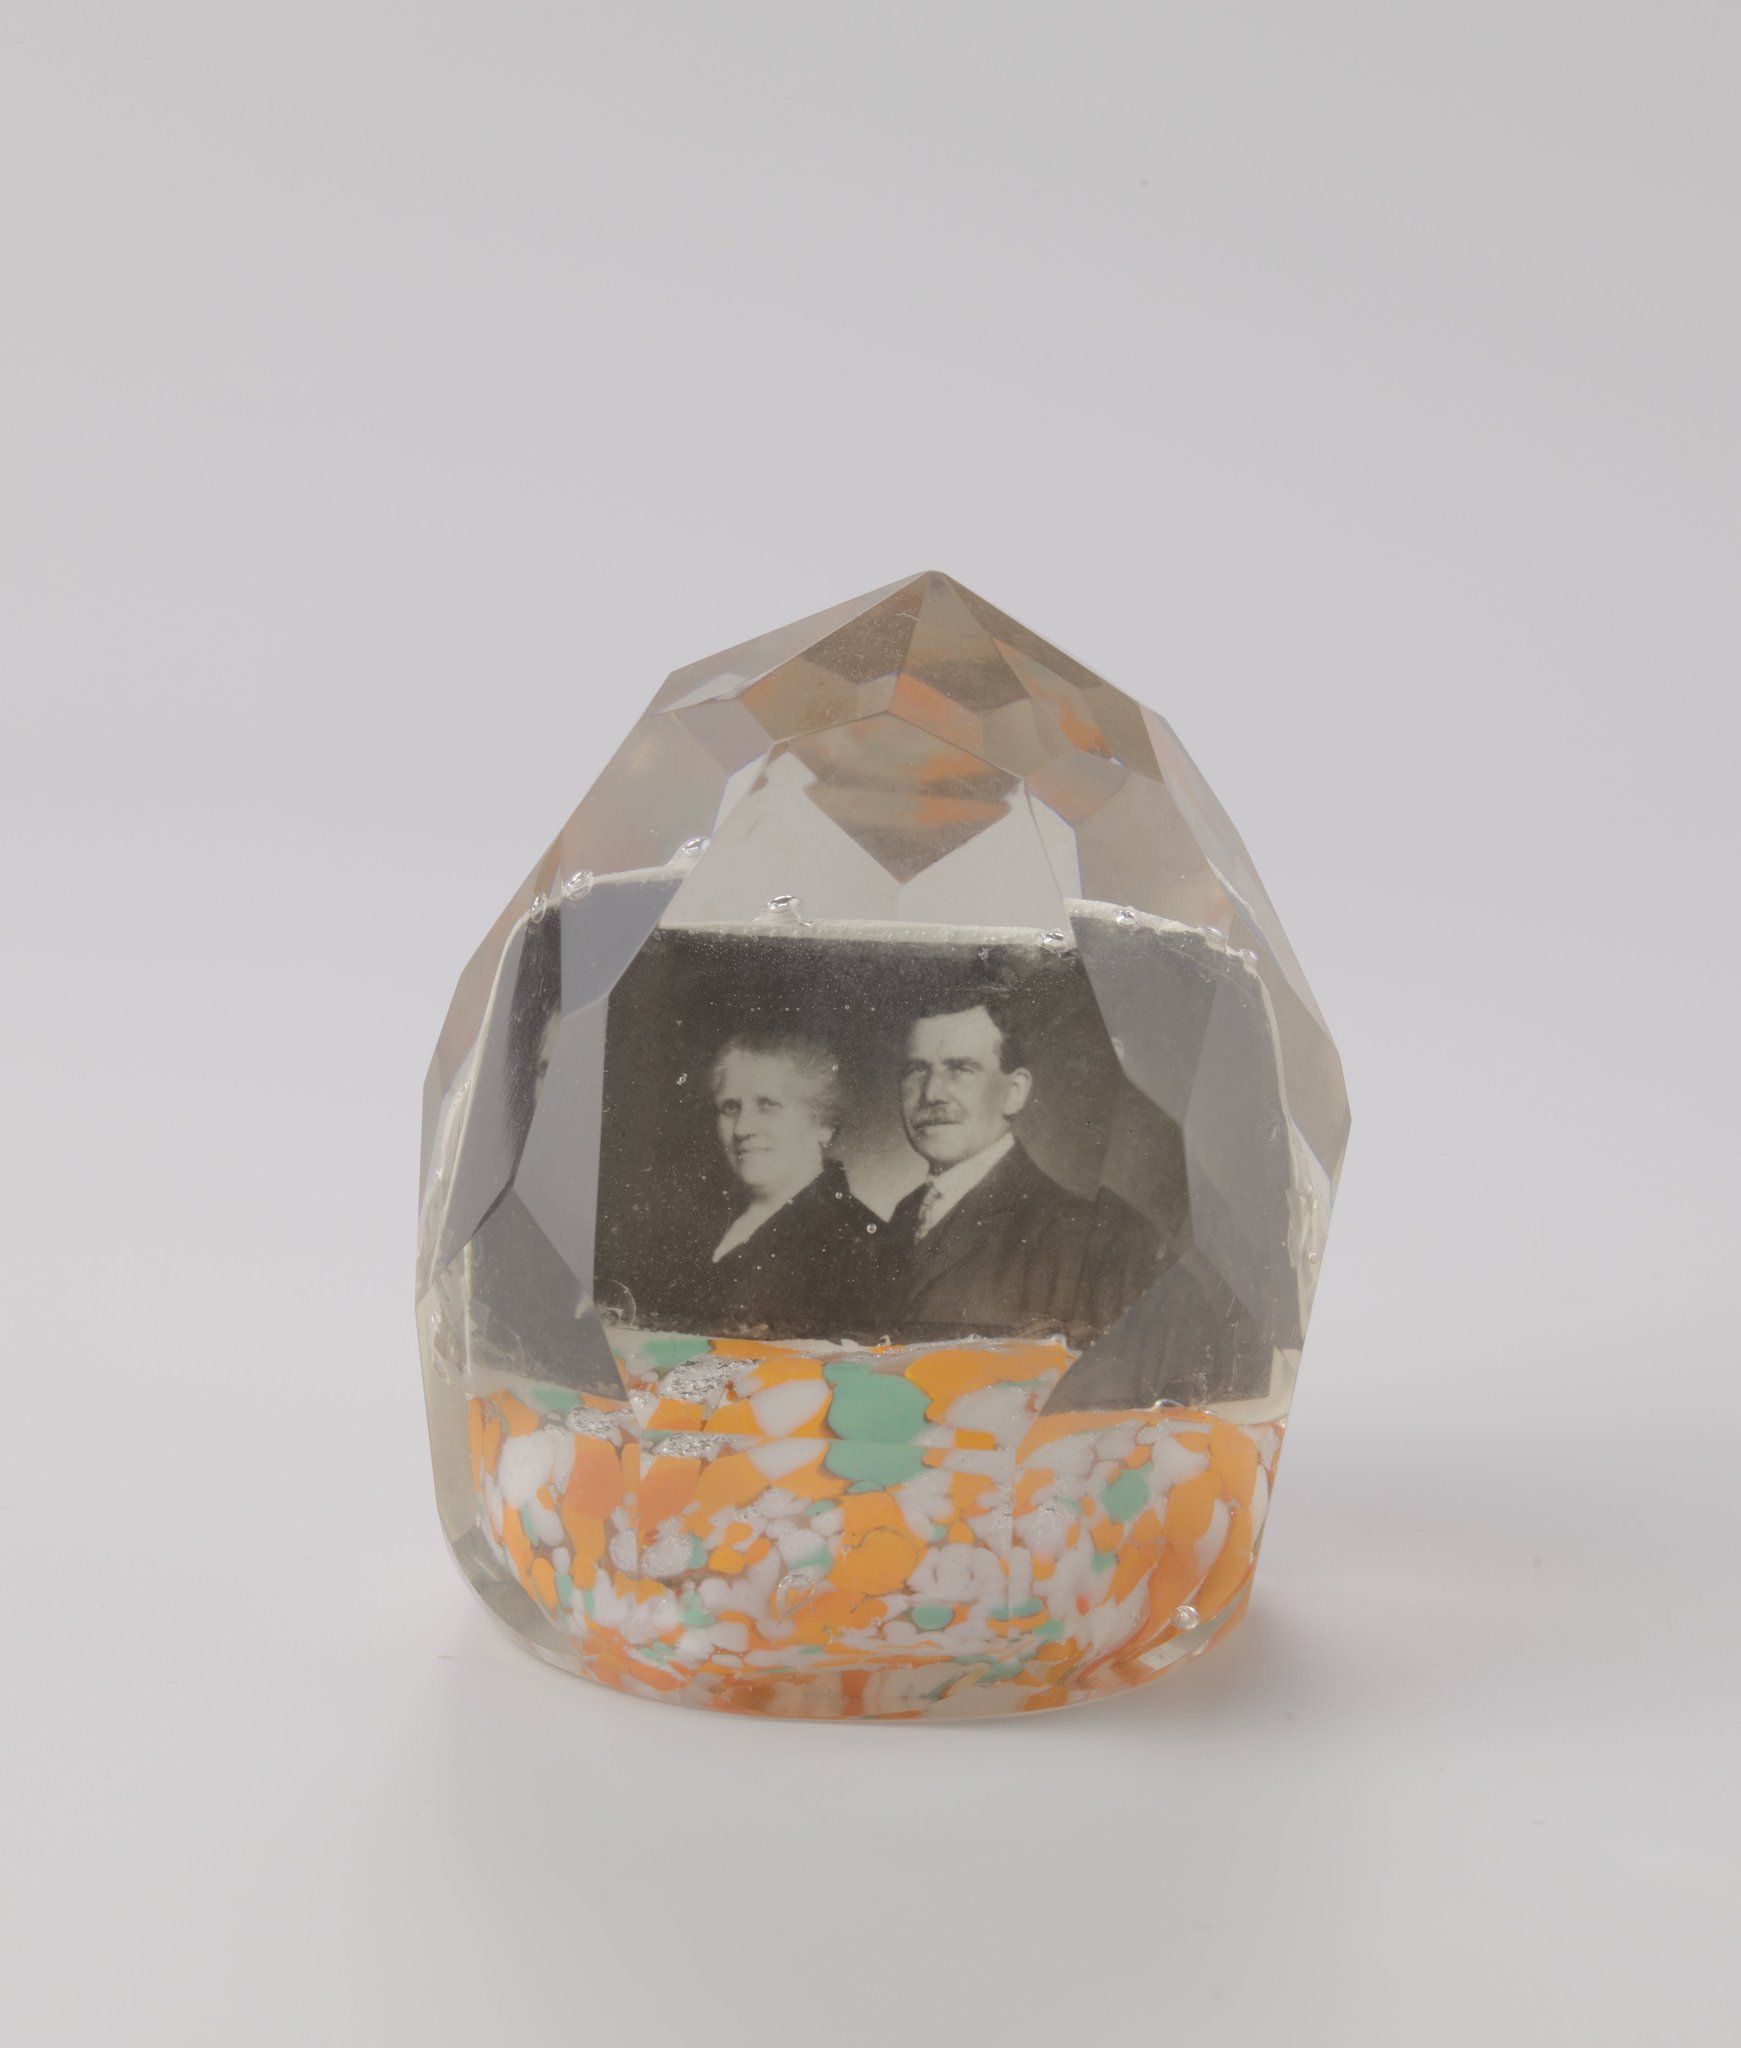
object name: paperweight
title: Presse-papier met dubbelportret van een man en vrouw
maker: Anonymous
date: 1800-1900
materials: glass